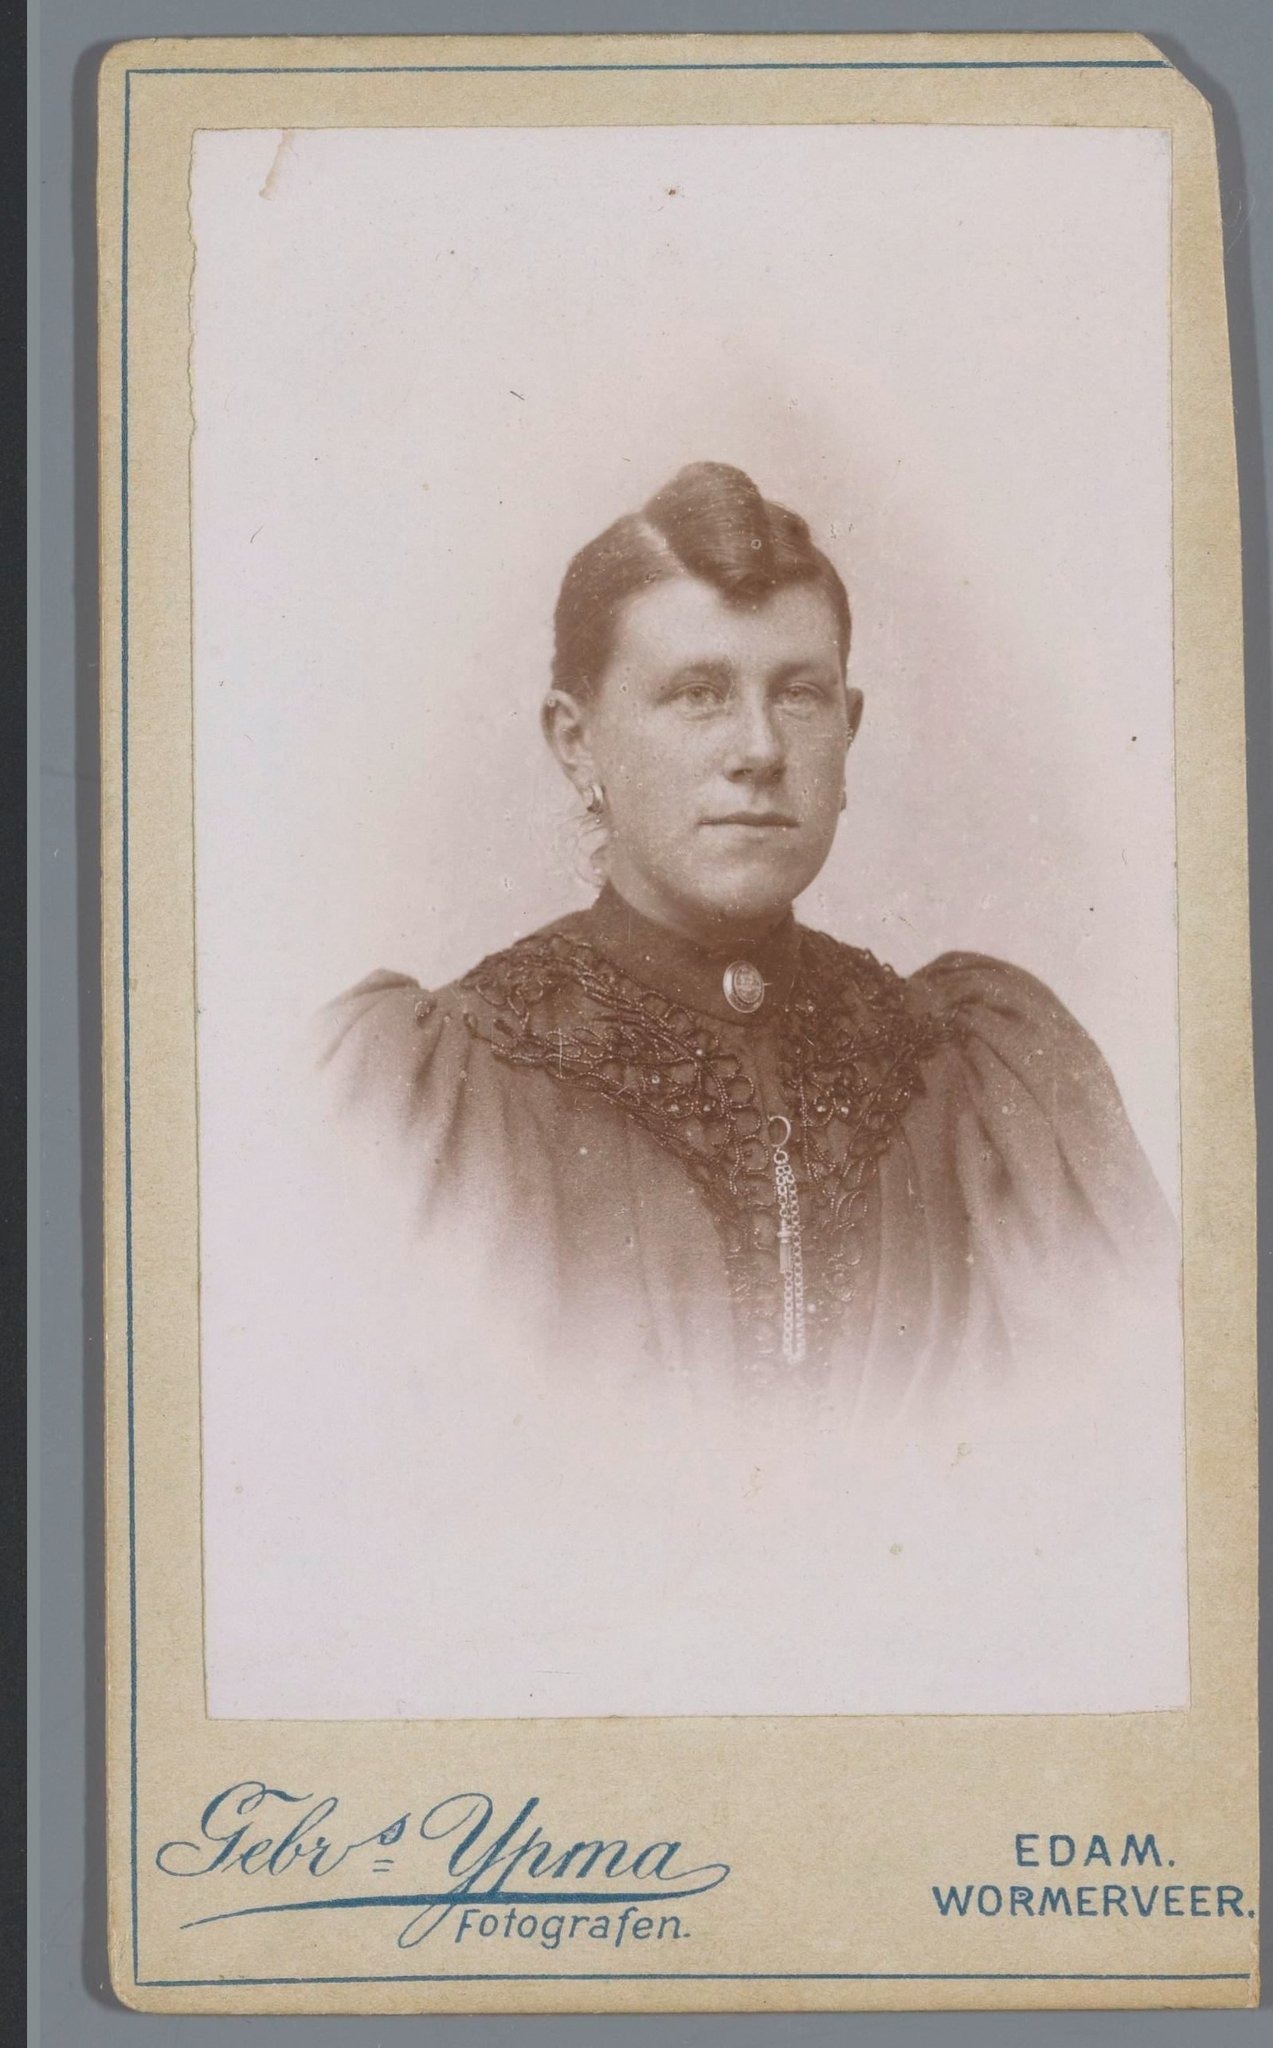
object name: photograph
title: Portret van Grietje Kelderman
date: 1894-1898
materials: cardboard, photographic support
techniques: collodion silver print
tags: historical persons - bb - woman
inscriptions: inscription: ‘ATELIER/ voor/ ONVERANDERLIJKE/ PORTRETTEN/ Gebroeders Ypma/ EDAM/ WORMERVEER/ Wandelweg./ Speciale inrichting voor vergrootingen./ Het cliché blijft voor nabestelling bewaard.’, inscription: ‘Grietje Kelderman’